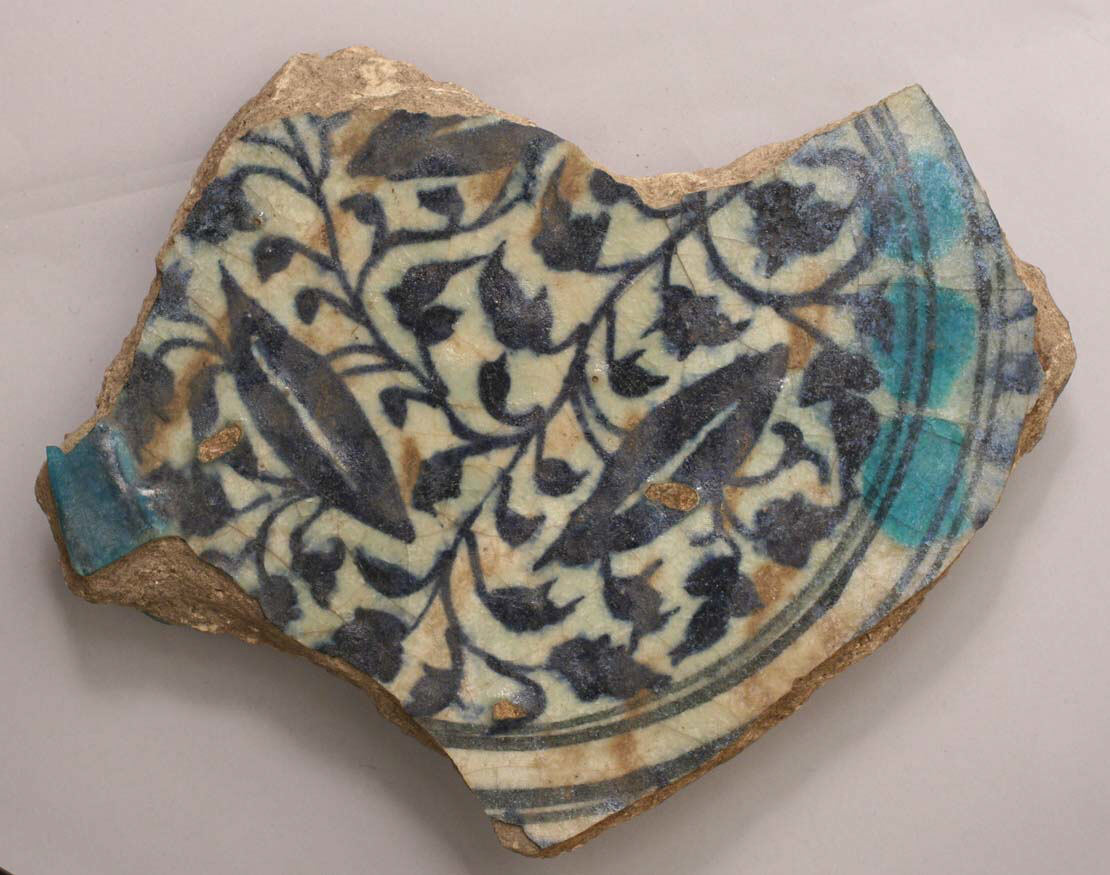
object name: fragment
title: Ceramic Fragment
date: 1301-1500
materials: glaze, stonepaste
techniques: underglaze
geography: egypt or syria